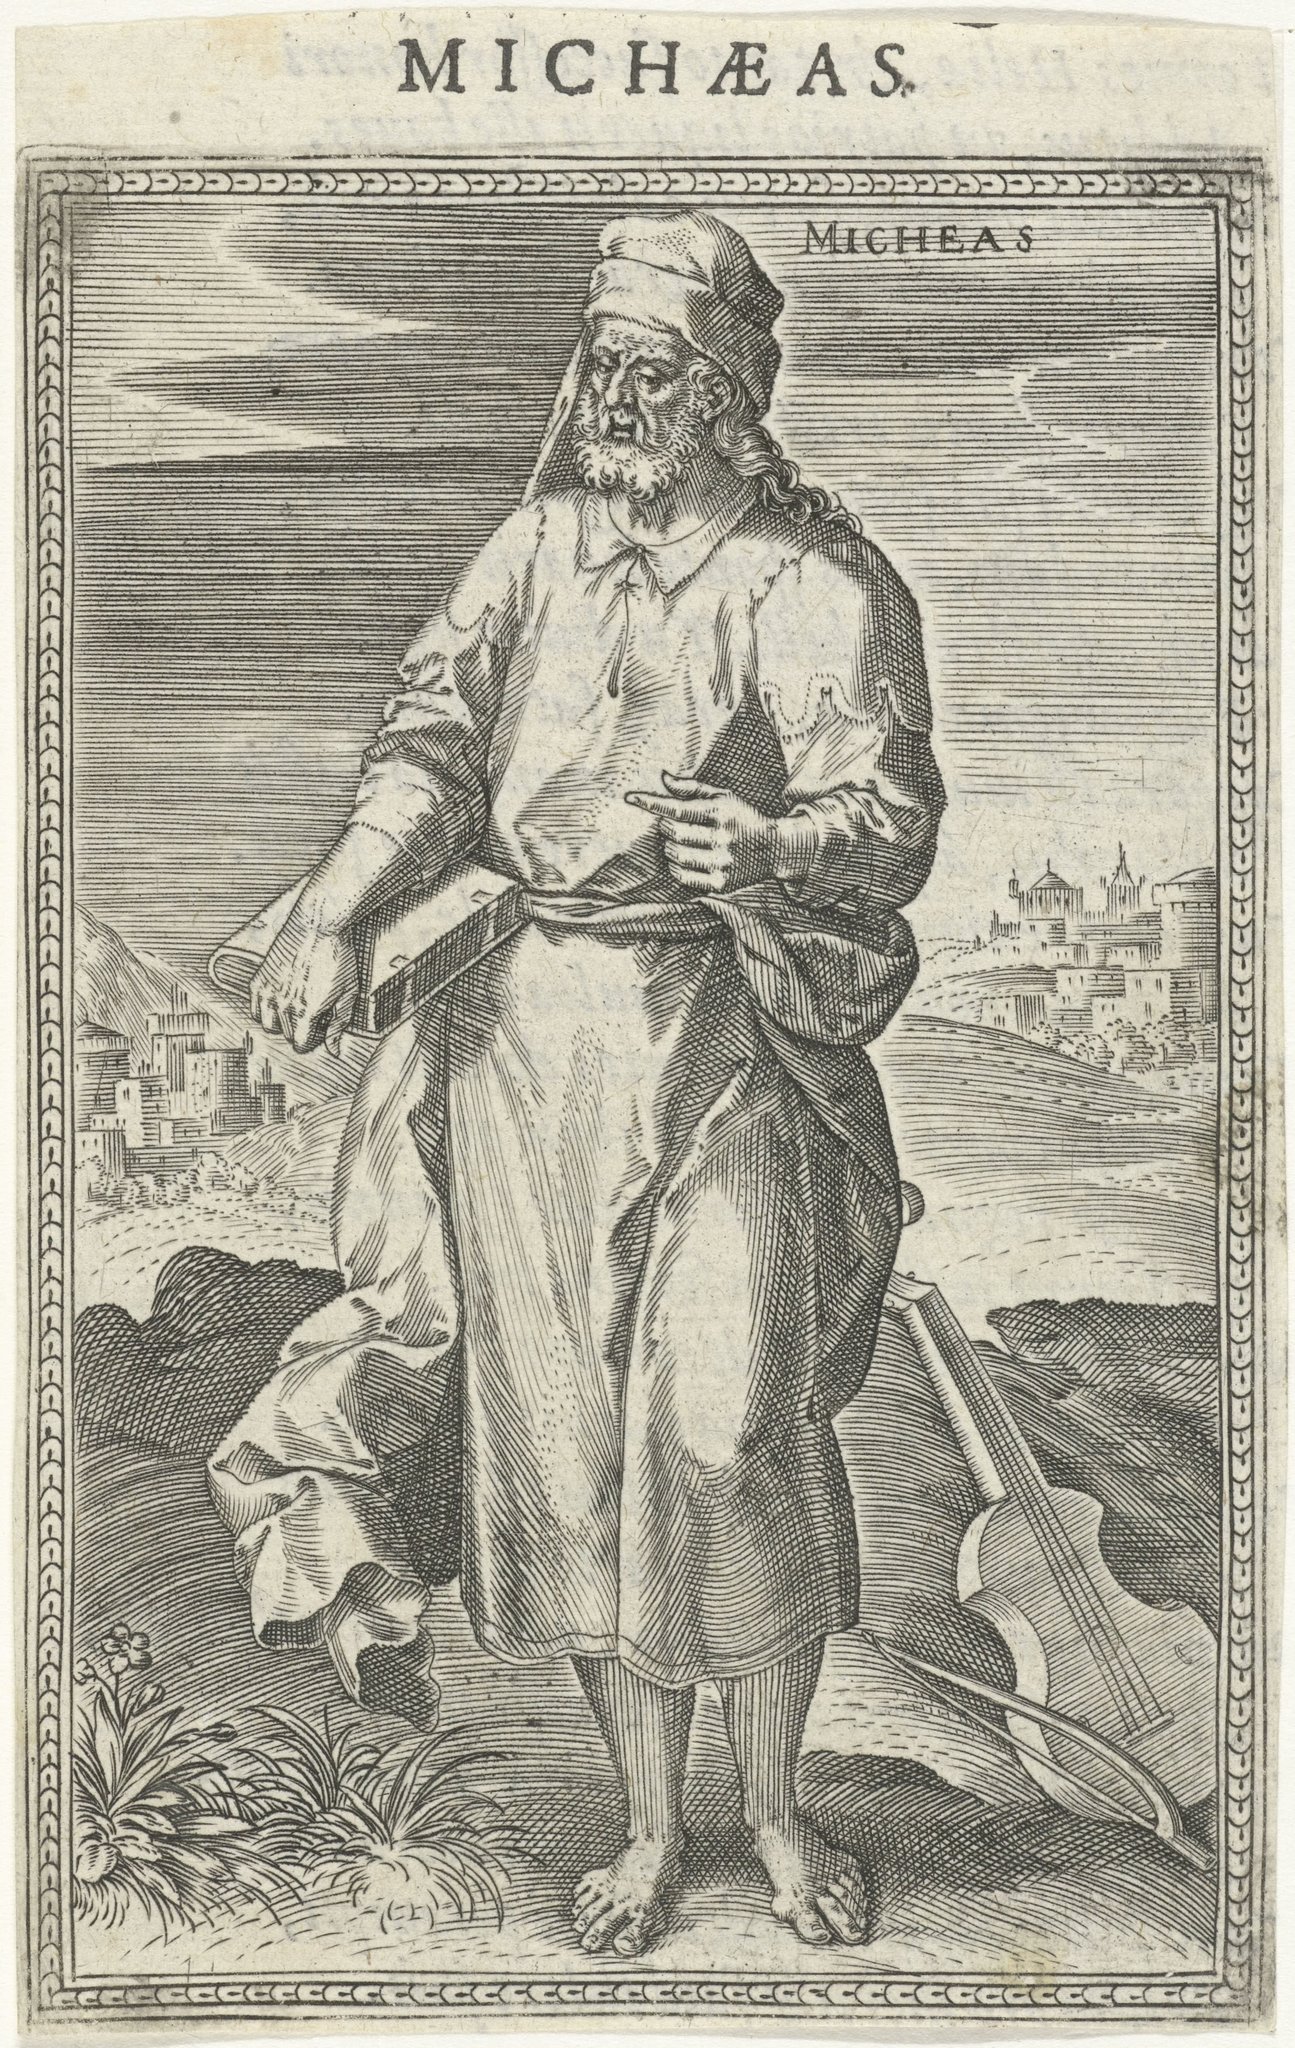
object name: book illustration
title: Michaeas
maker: johann sadeler (i)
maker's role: print maker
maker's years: 1550-1600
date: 1577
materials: paper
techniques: engraving, letterpress printing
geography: antwerp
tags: male persons from the old testament (with name) (not in biblical context), violin, fiddle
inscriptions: collector's mark: Lugt 240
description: Boekillustratie voor Hillesem, Louis. Sacrarum antiquitatum monumenta. Antwerpen: Christoffel Plantin, 1577.